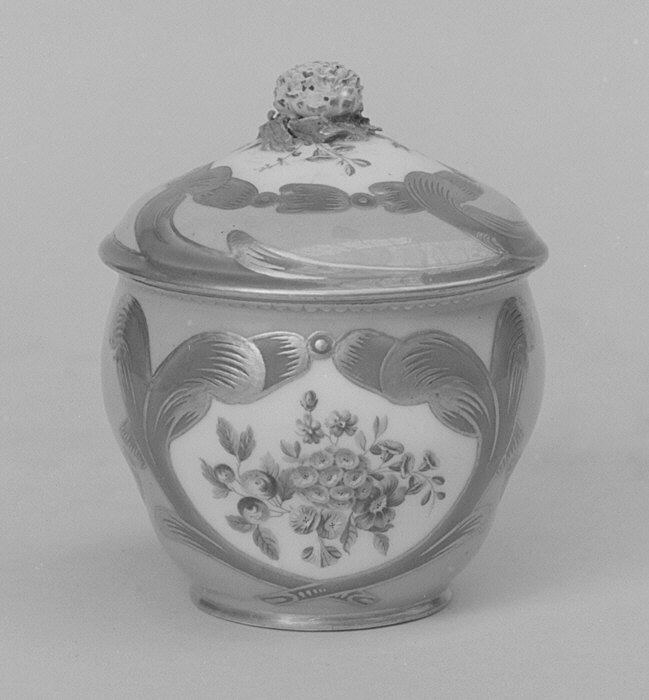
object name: sugar bowl with cover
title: Sugar bowl with cover (pot à sucre Hébert) (part of a service)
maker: sèvres manufactory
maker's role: manufactory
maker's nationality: french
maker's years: 1740-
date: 1759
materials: soft paste porcelain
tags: flowers